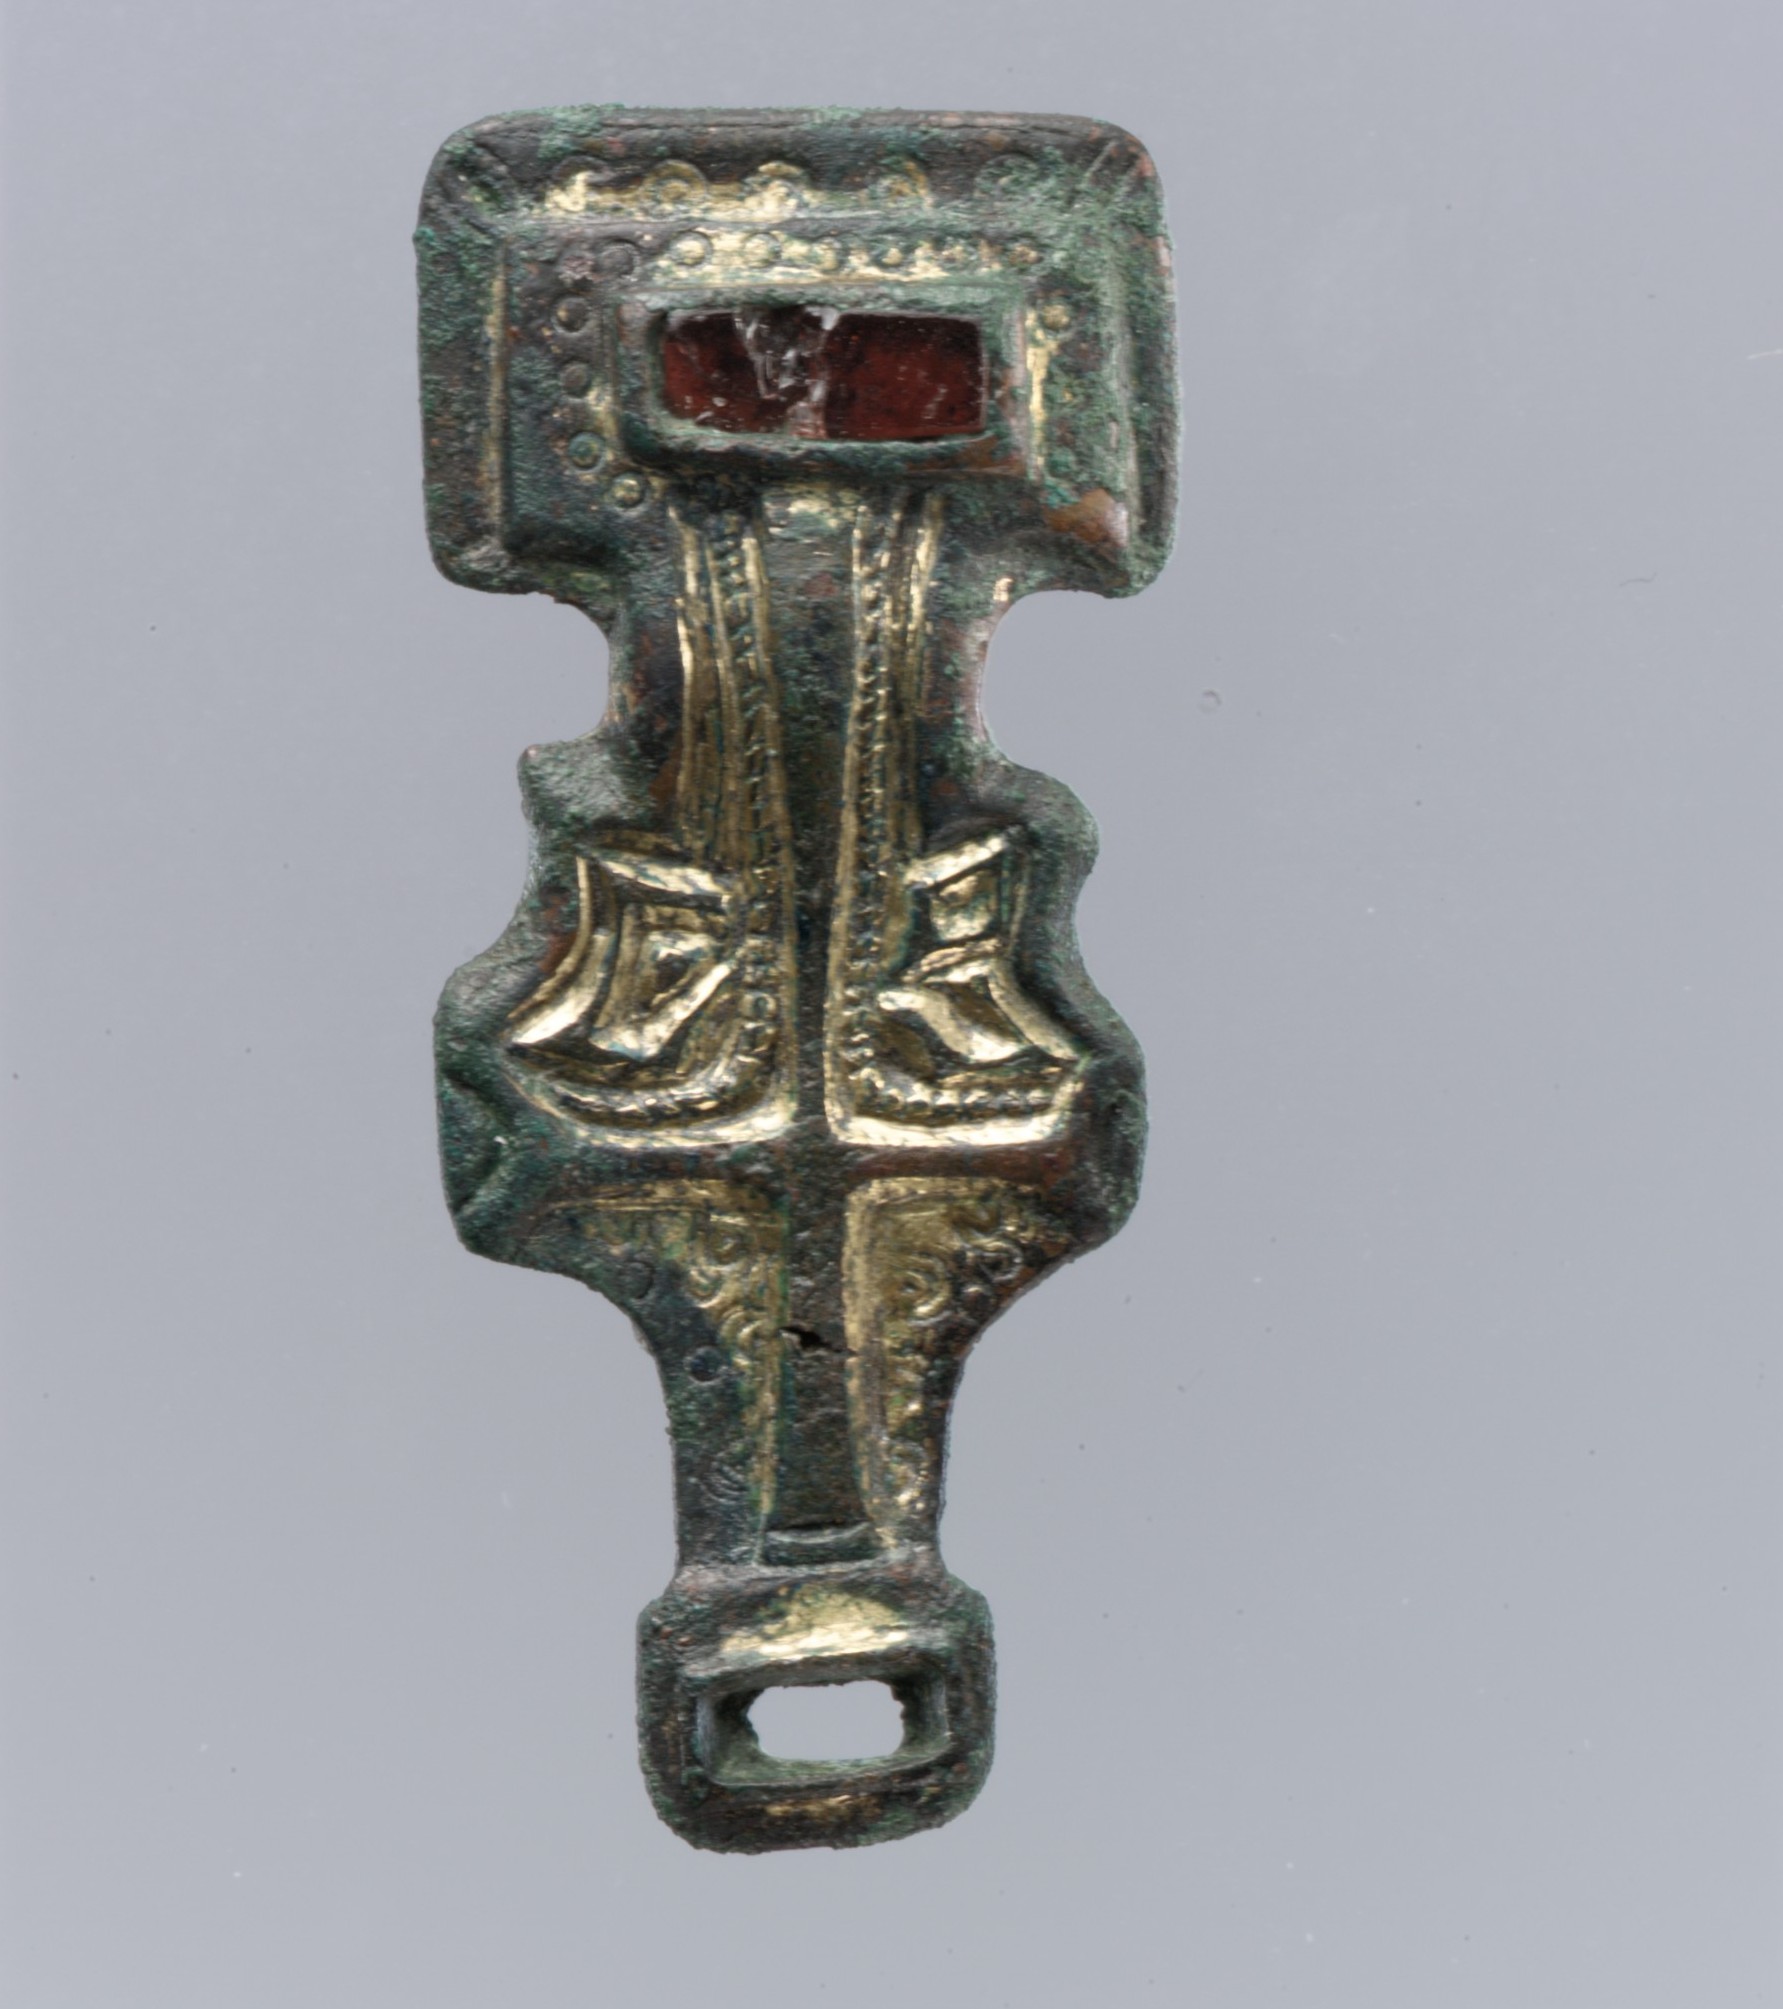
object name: brooch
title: Miniature Square-Headed Brooch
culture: anglo-saxon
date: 501-550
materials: gemstone, iron, silver gilt